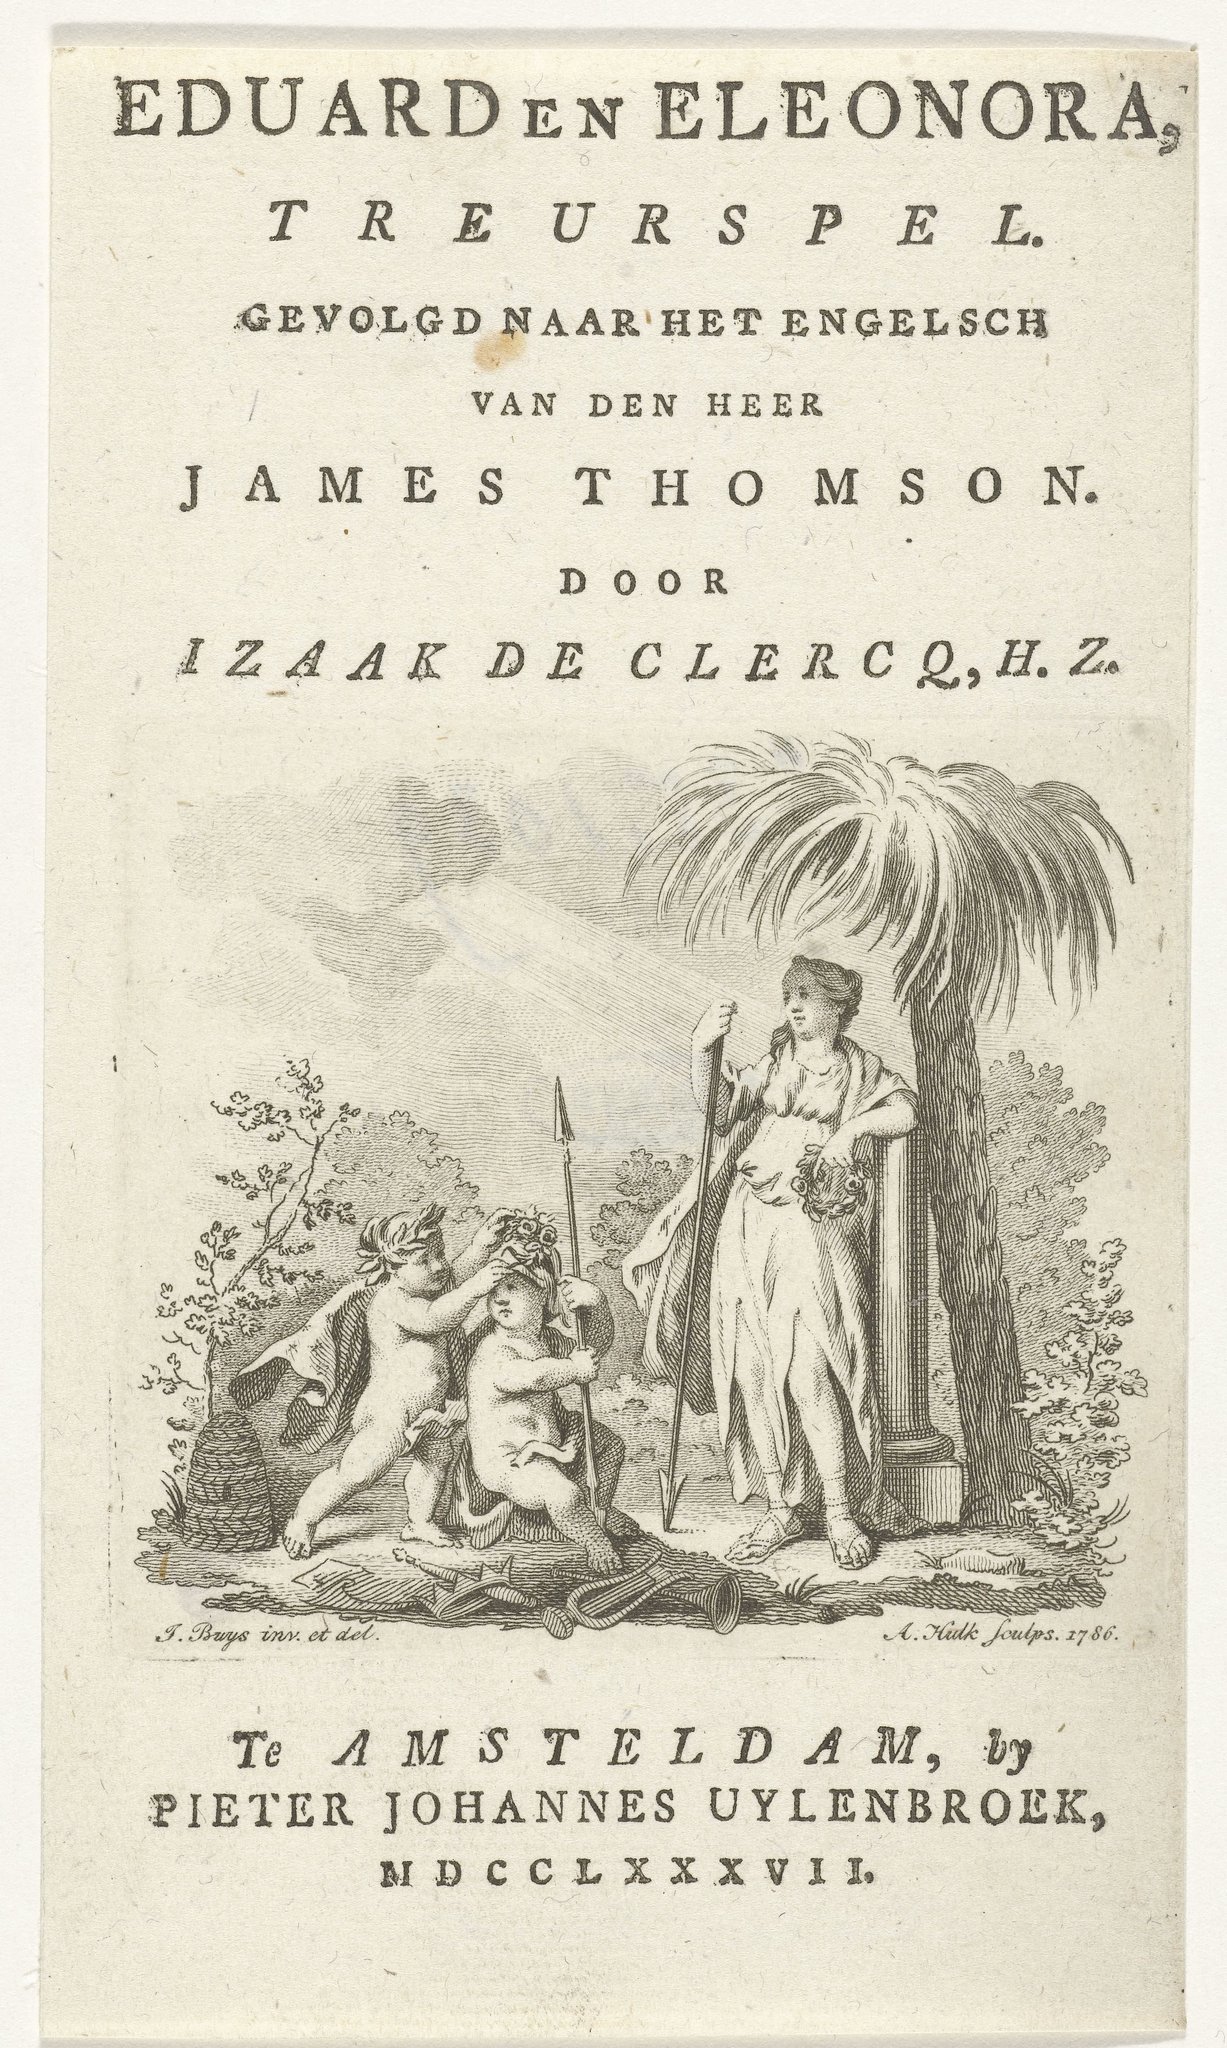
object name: print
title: Titelpagina voor: Izaak de Clercq, Eduard en Eleonora, 1787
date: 1786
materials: paper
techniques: engraving, etching, letterpress printing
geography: amsterdam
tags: the arts of the stage: ballet, theatre, musical drama, motion picture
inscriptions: collector's mark: Lugt 2760, collector's mark: Lugt 2228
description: Twee met rekwisieten spelende putti links. Rechts een tegen een zuil leunende vrouw, met een krans in de ene en een speer in de andere hand. Uiterst links een palmboom. Uiterst rechts een bijenkorf, symbool van de Amsterdamse schouwburg. Voor de twee putti liggen rekwisieten op de grond. Onder andere een kroon, een harp en een trompet.